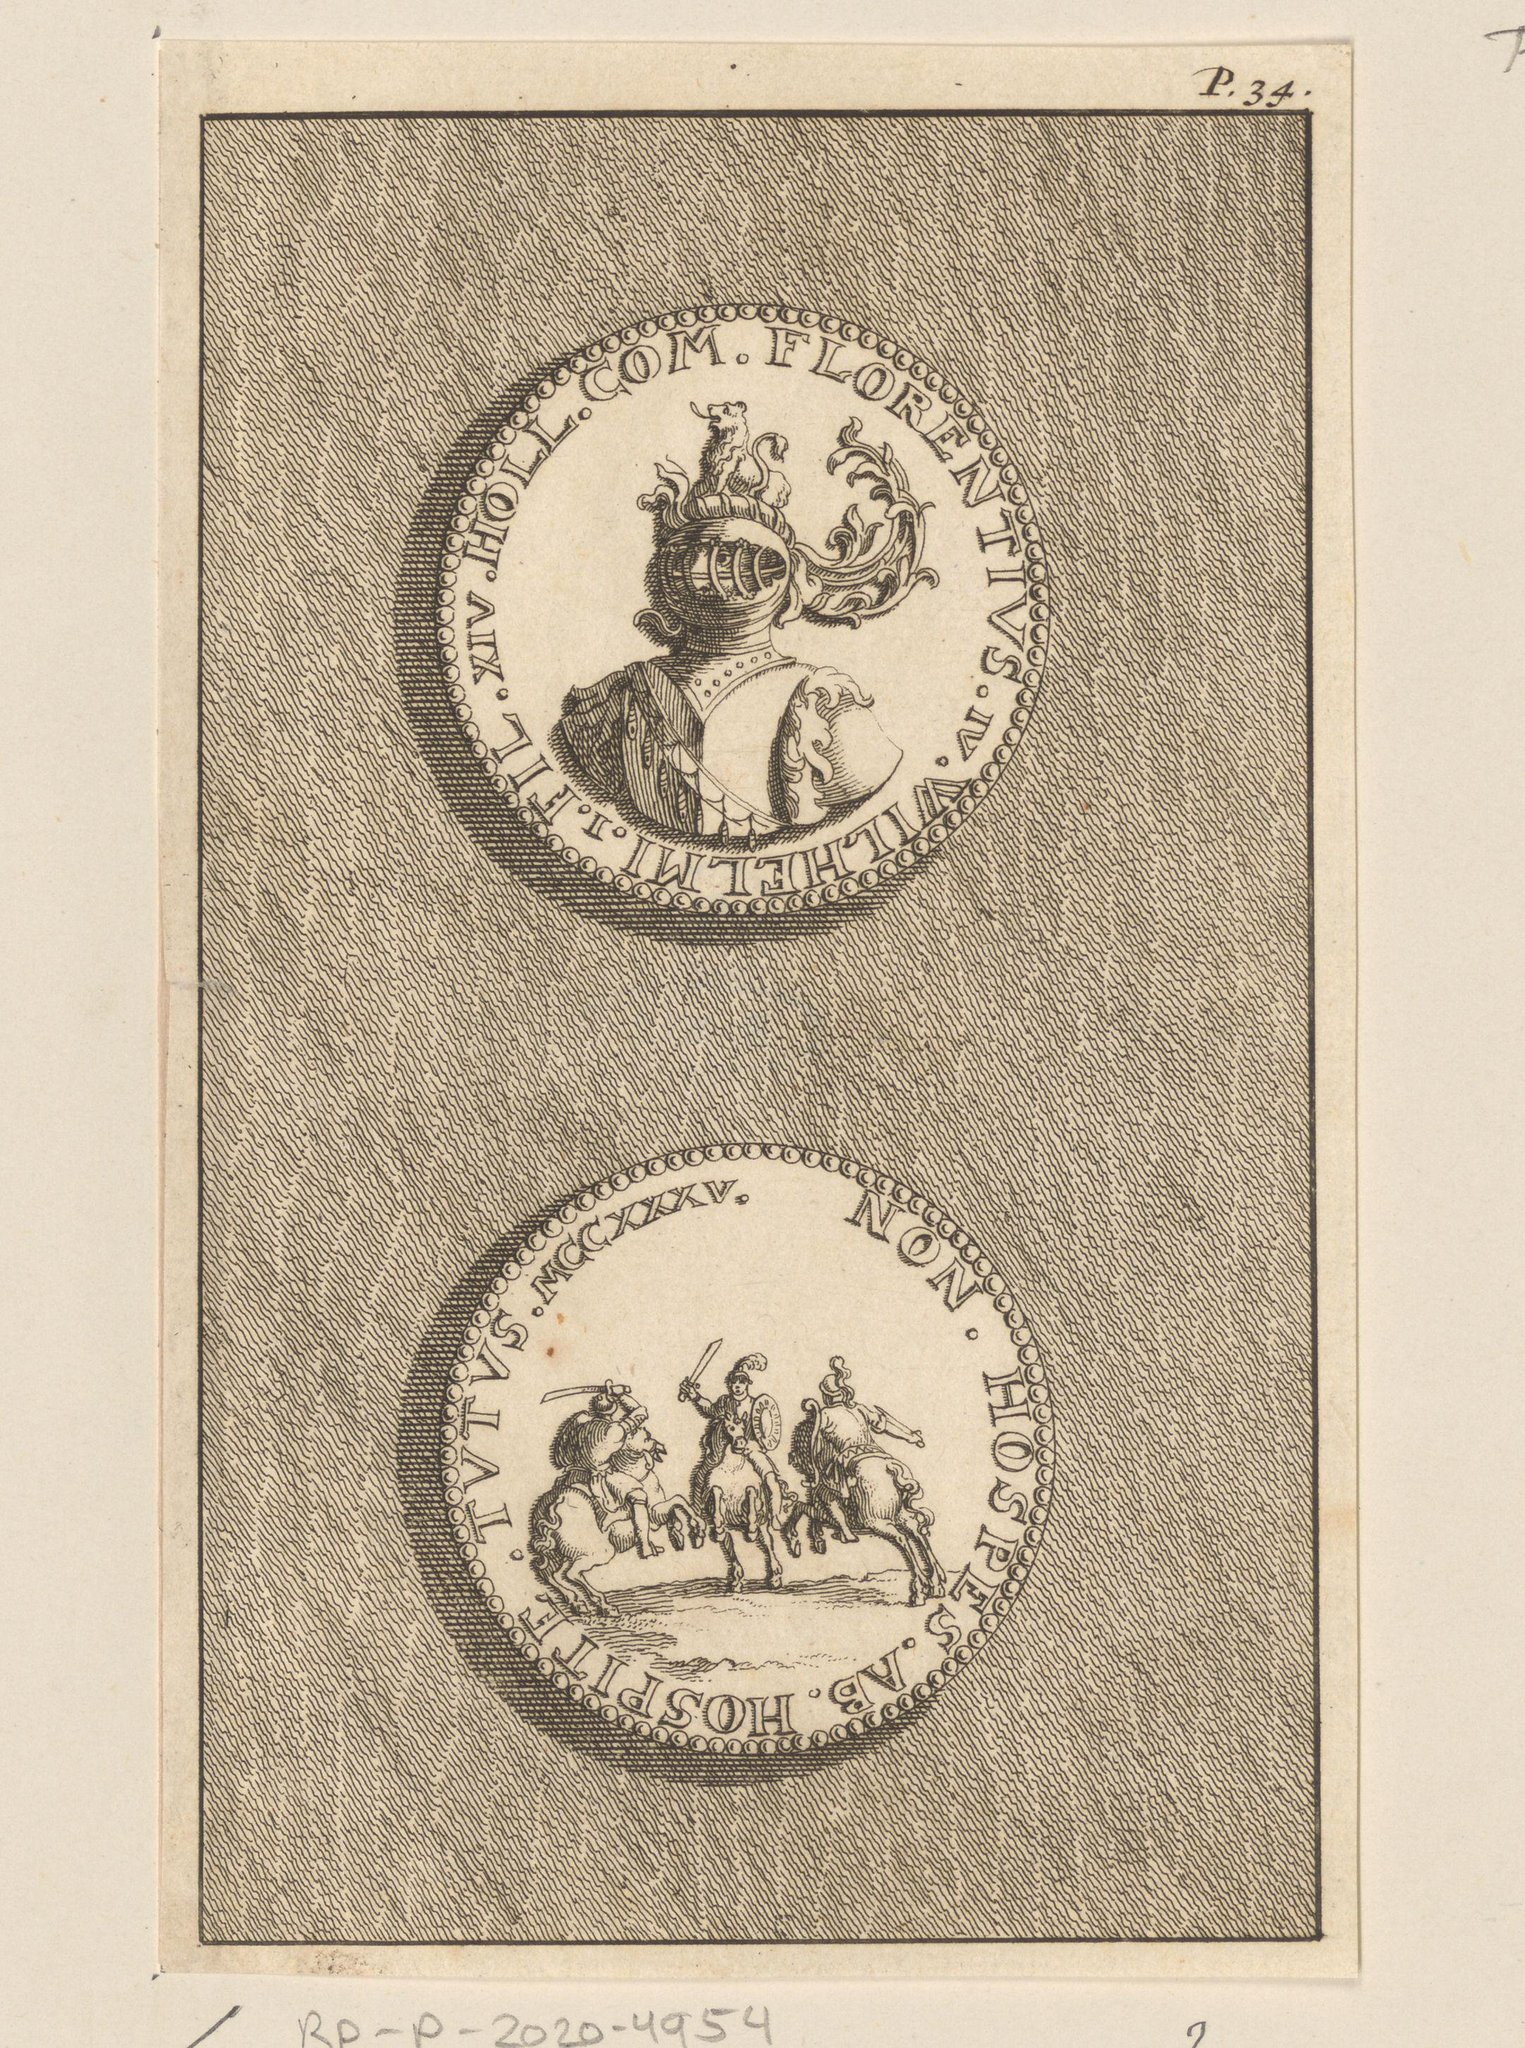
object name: book illustration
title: Voor- en achterzijde van een munt met het portret van Floris IV, graaf van Holland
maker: Anonymous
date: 1700-1750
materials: paper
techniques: etching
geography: northern netherlands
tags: floris iv (graaf van holland), riding a horse, ass, or mule; rider, horseman, armour, historical persons, coin, ruler, sovereign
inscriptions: collector's mark: Lugt 964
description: Prent komt uit een onbekende publicatie.